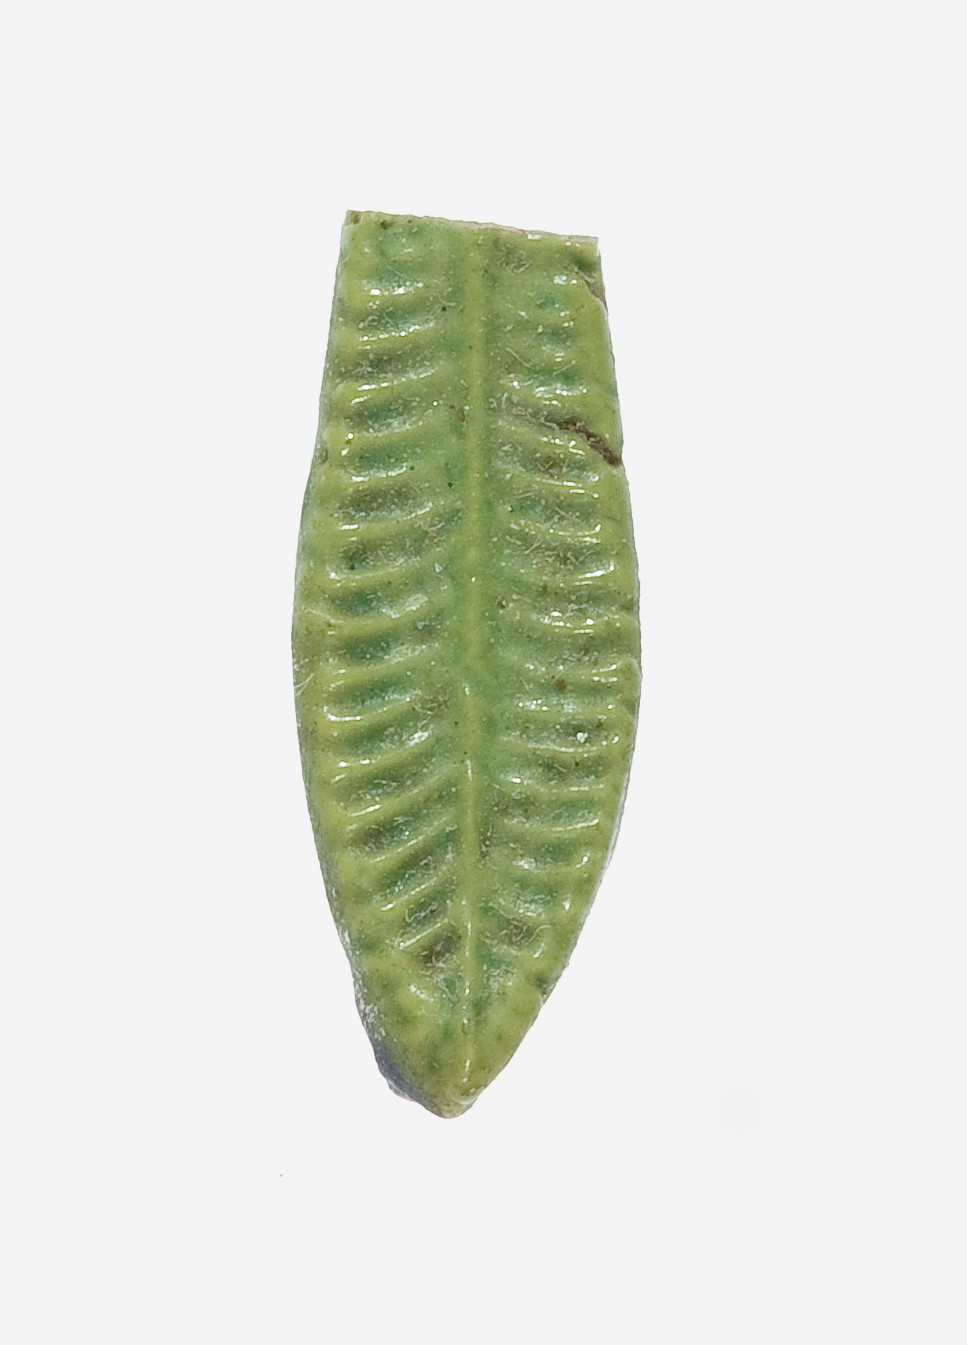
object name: pendant, leaf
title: Leaf Pendant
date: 1390-1352 BCE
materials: faience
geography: egypt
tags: leaves